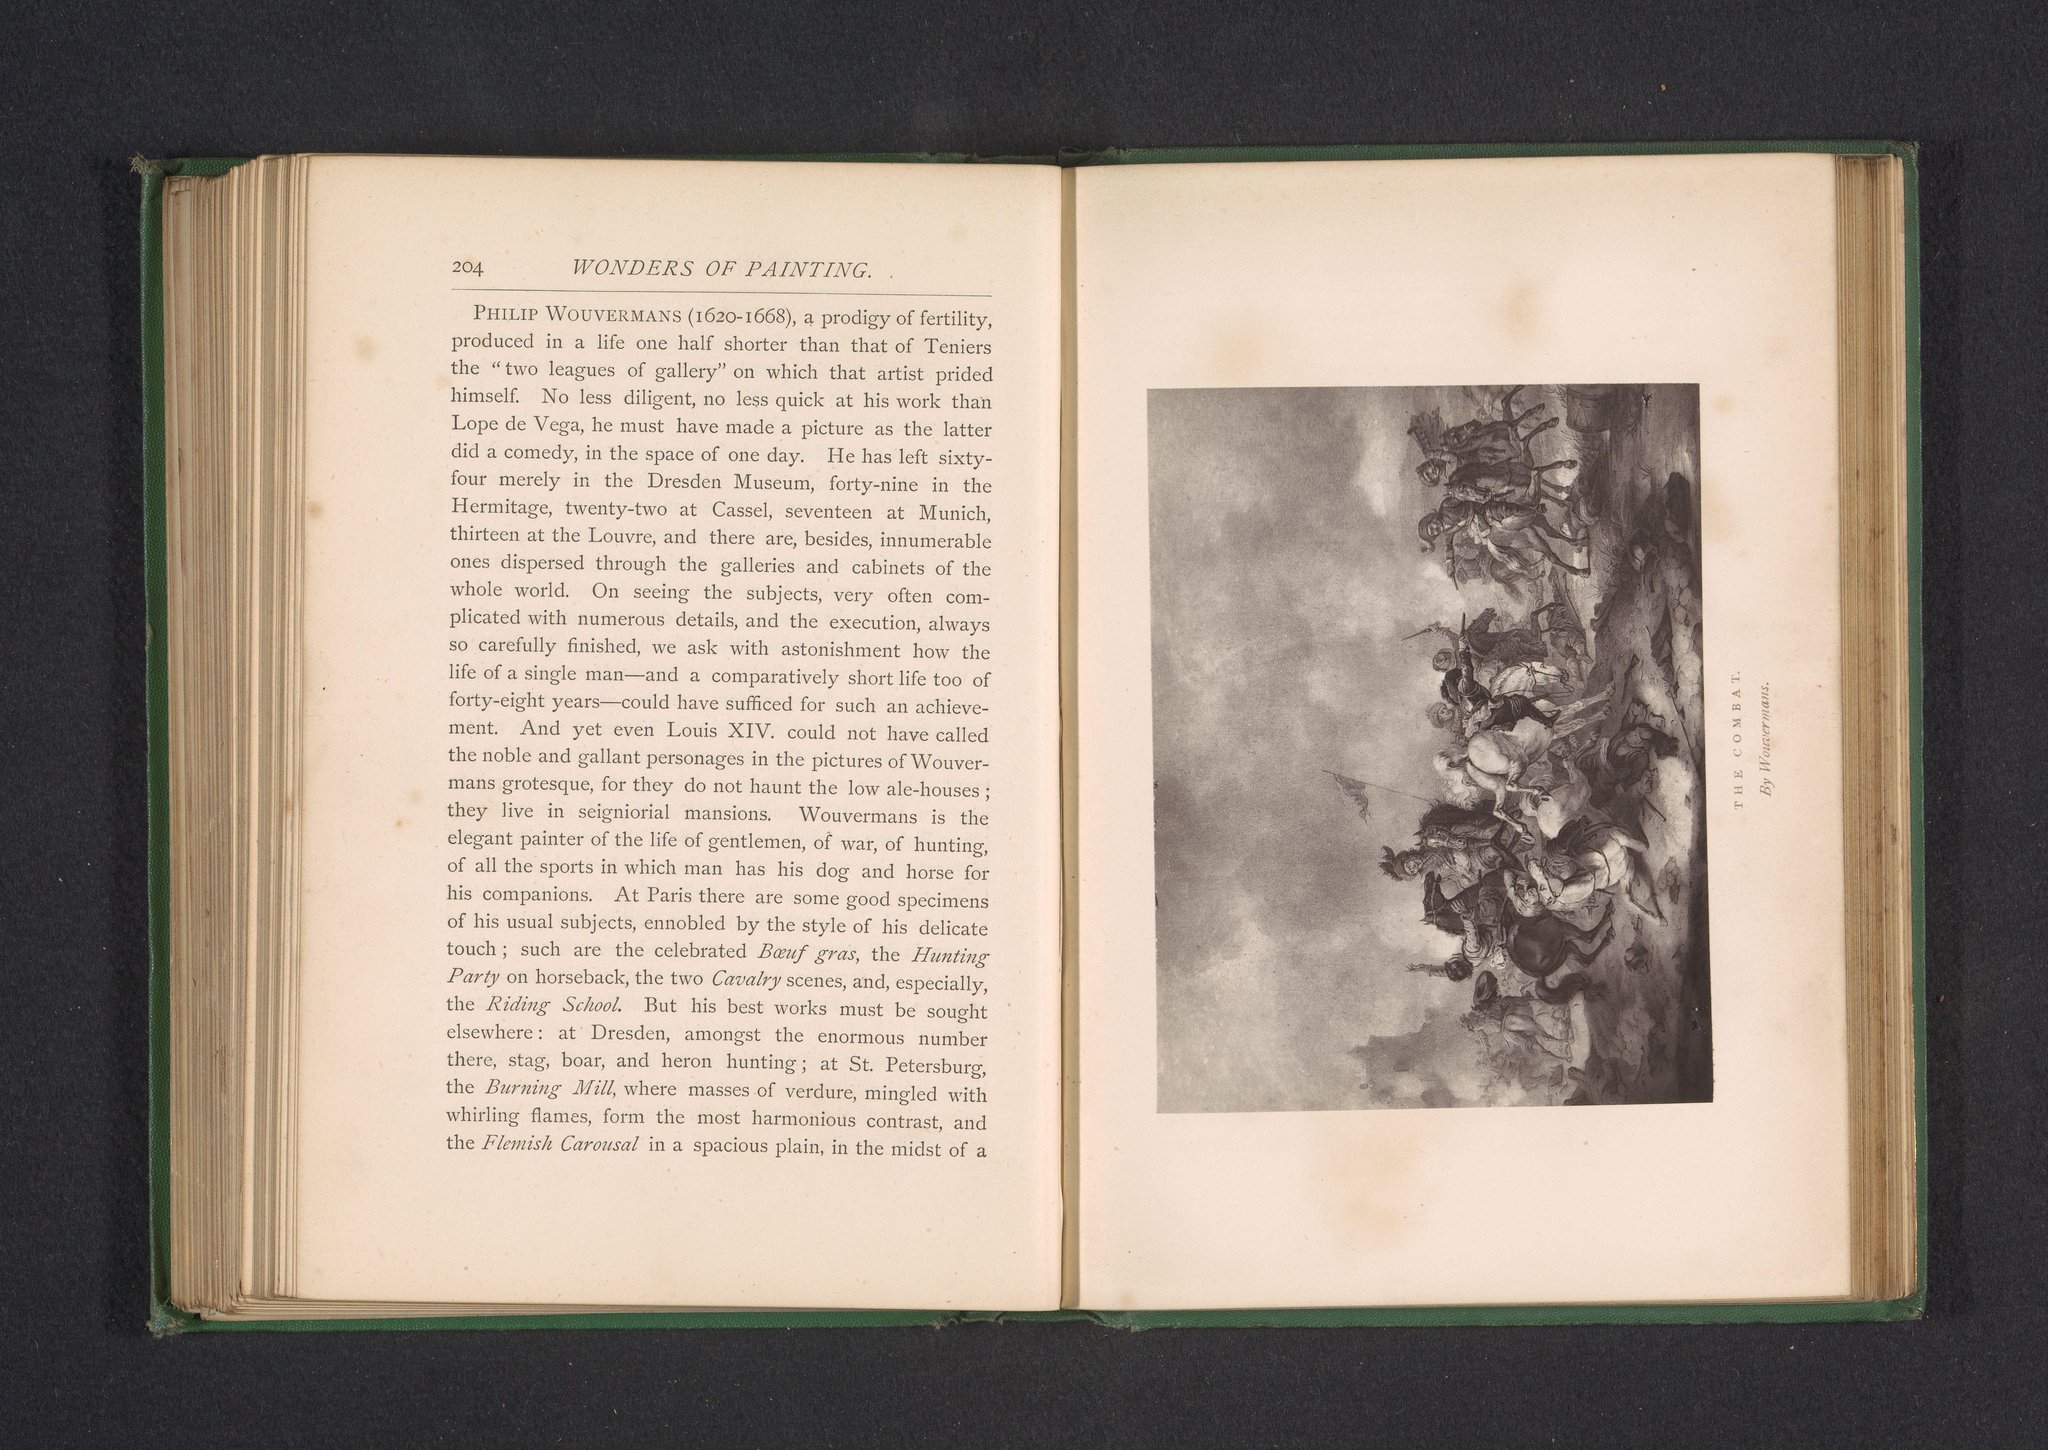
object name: page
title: The combat. By Wouvermans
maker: Anonymous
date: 1861-1871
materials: paper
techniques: woodburytype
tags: battle